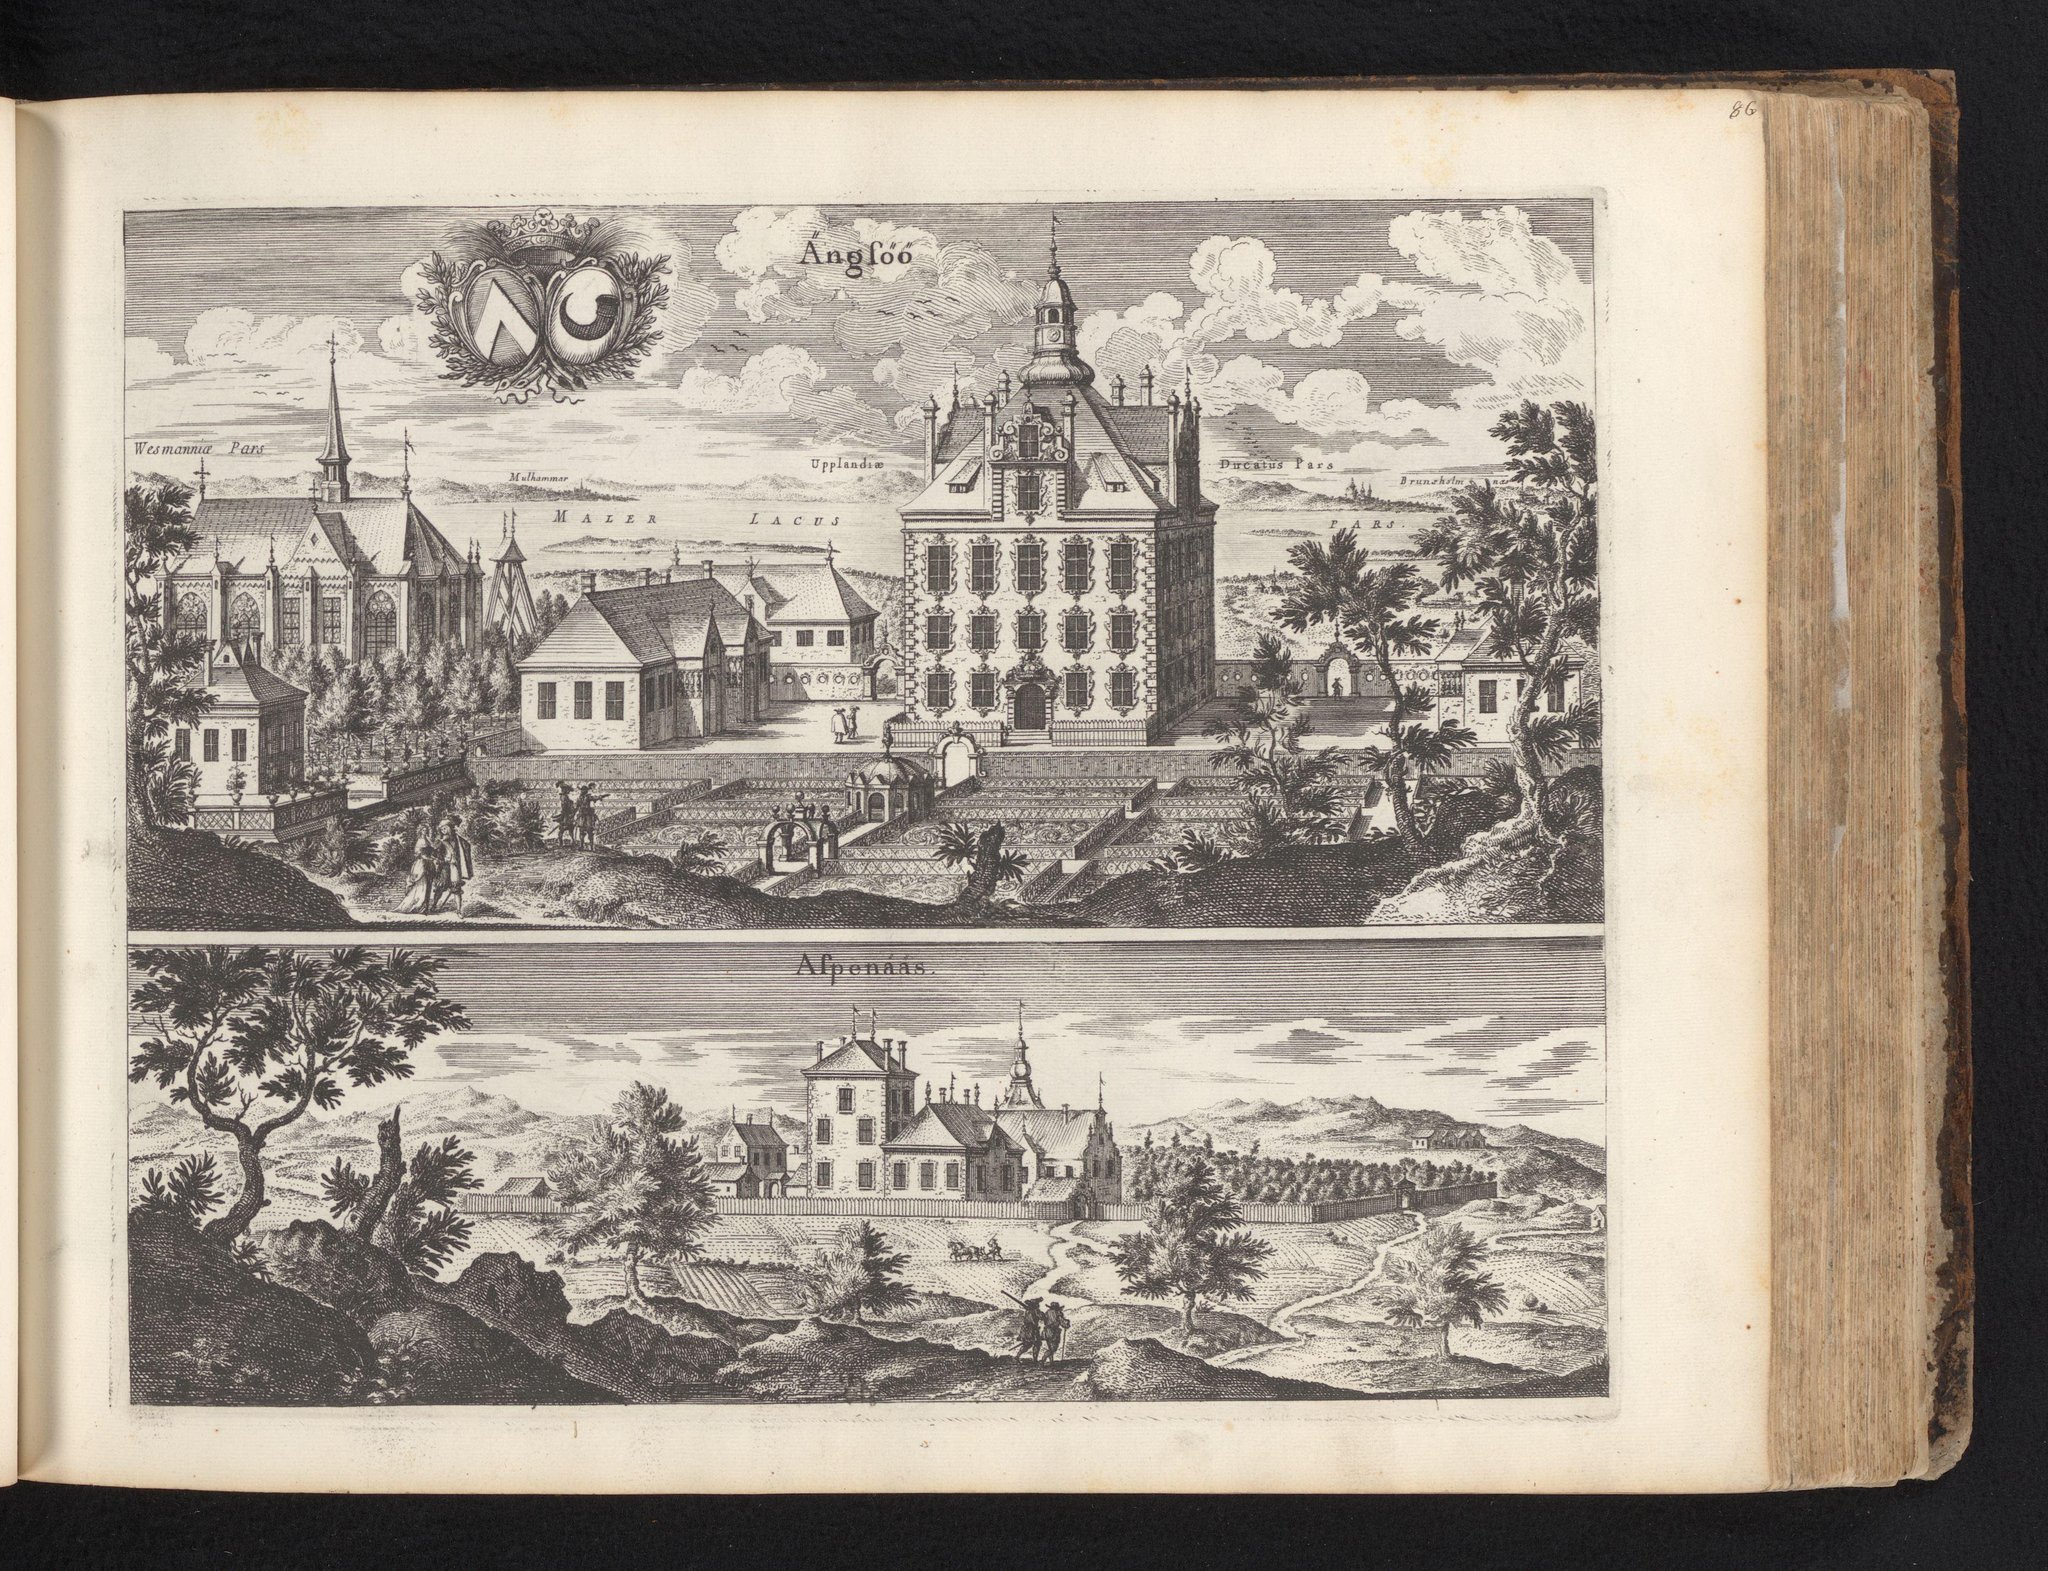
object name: print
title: Gezicht op slot Ängsö en het herenhuis Aspnäs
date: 1670-1674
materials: paper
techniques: etching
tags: palace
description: Kungliga Biblioteket, 'Suecia': http://www.kb.se/samlingarna/Kartor-bilder/Suecia-antiqua/ (geraadpleegd november 2016).